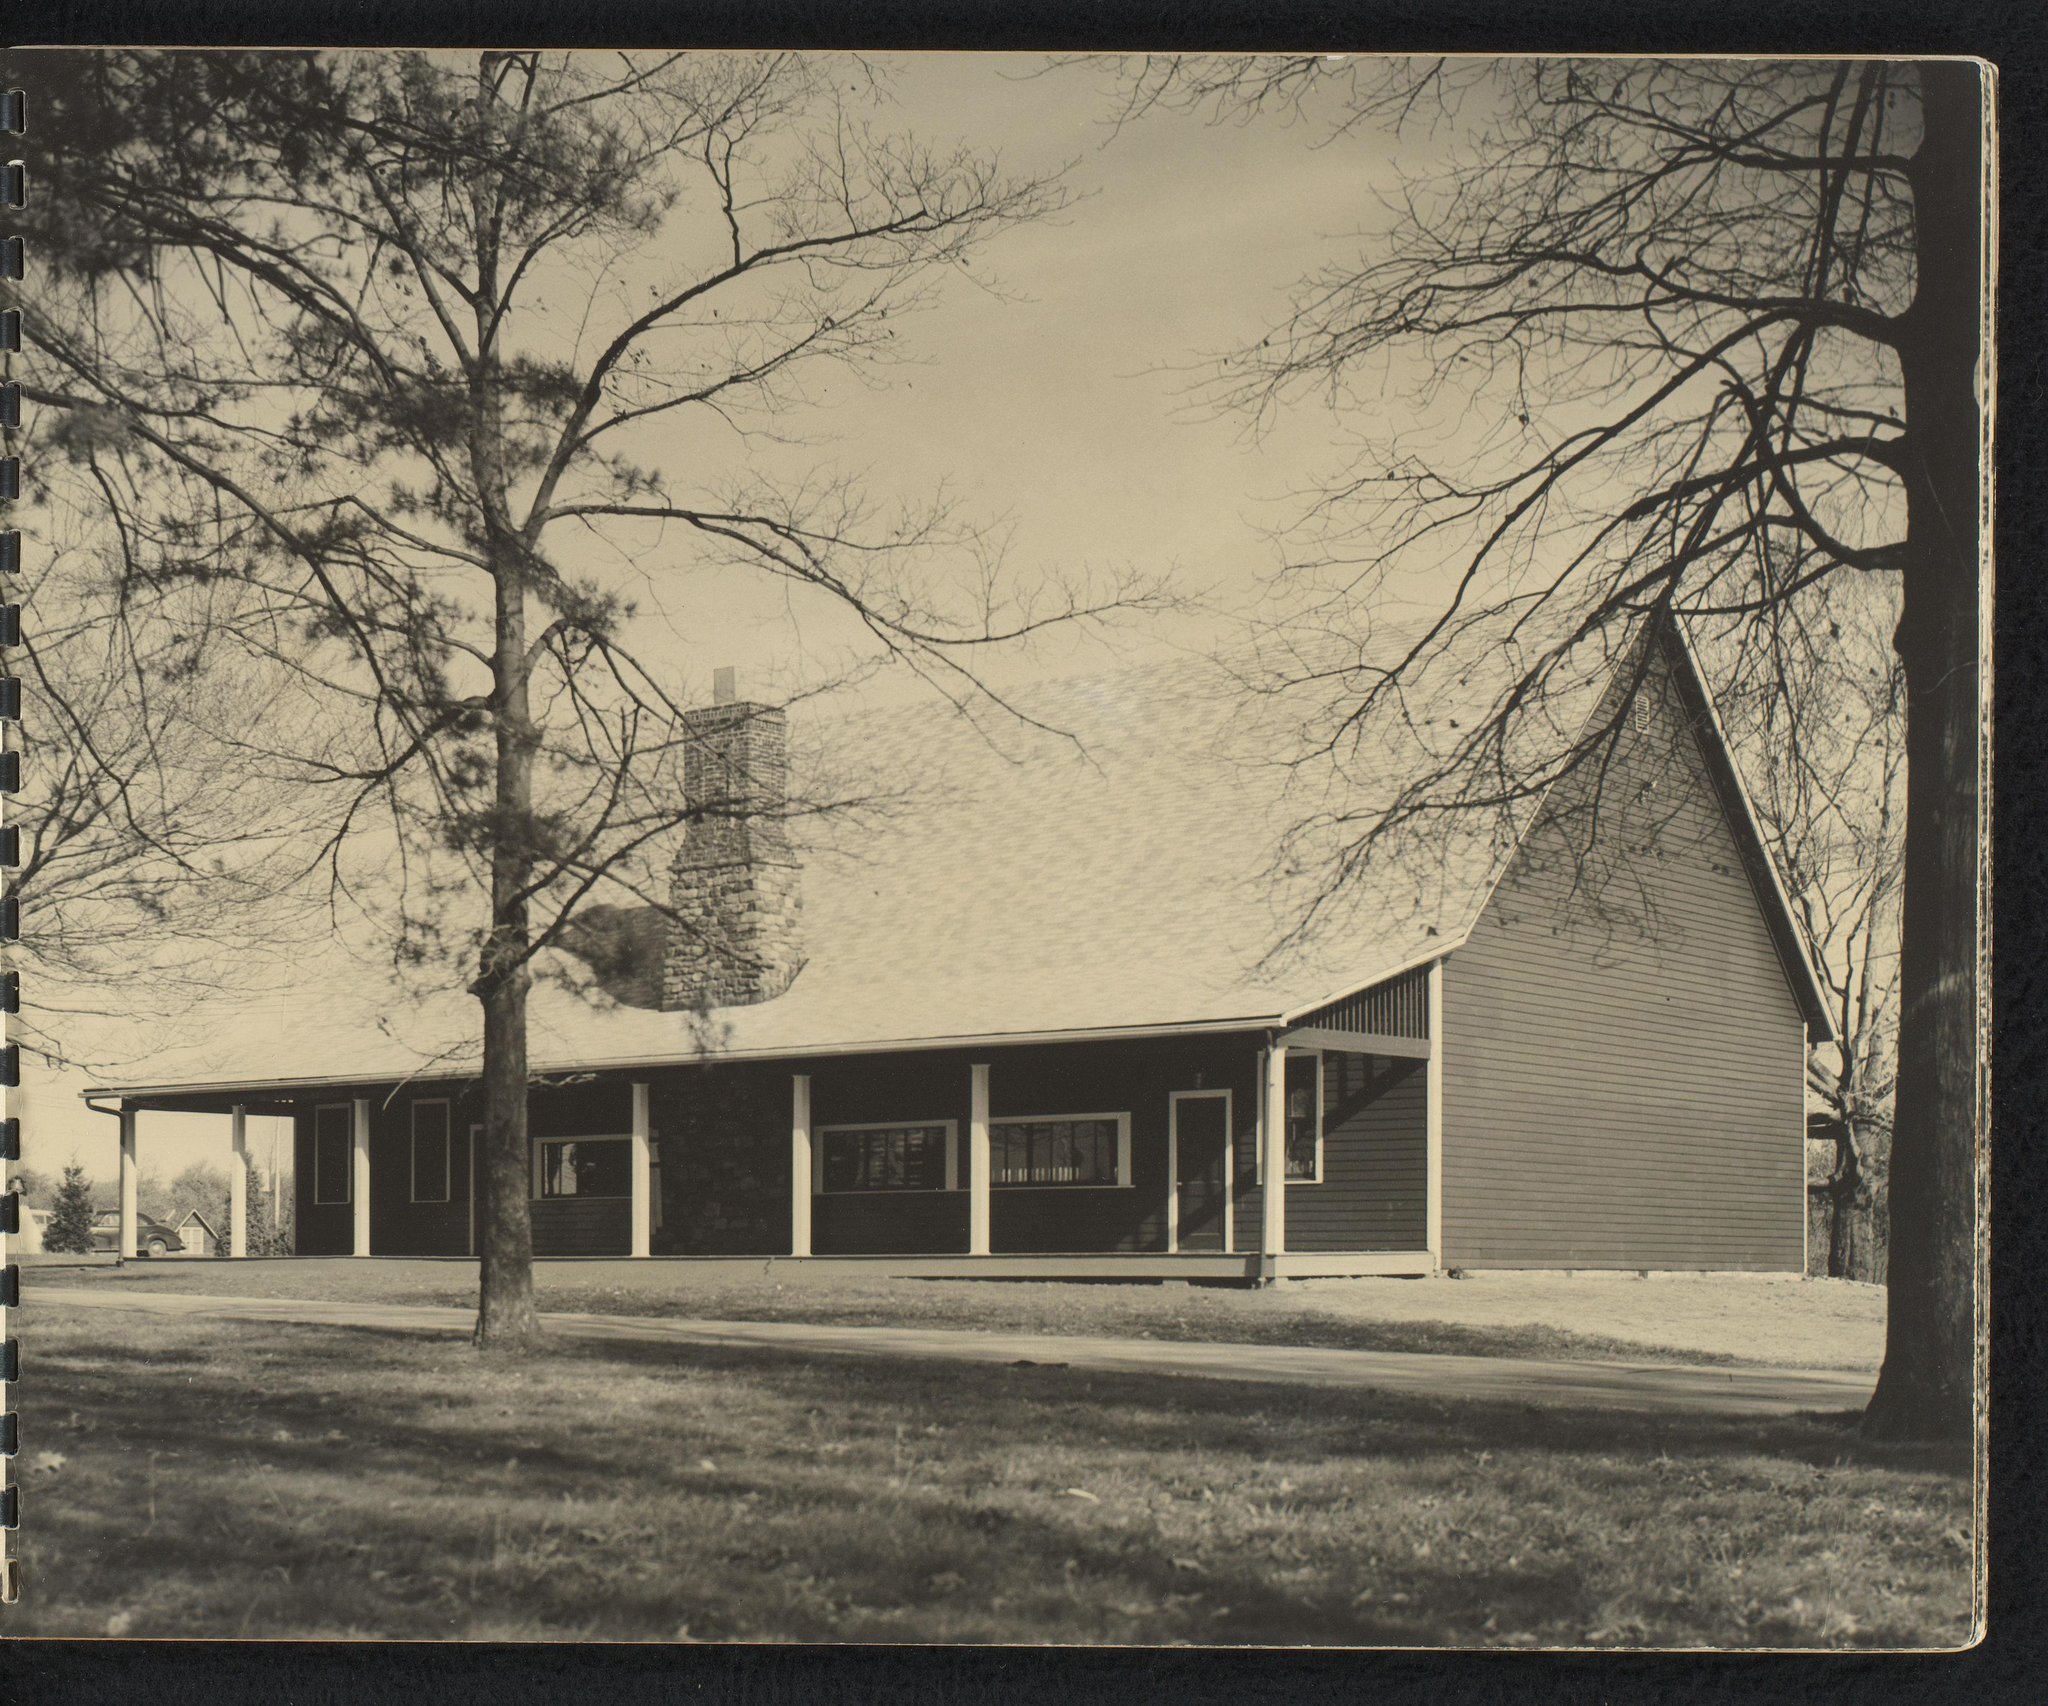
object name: photograph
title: Gymnastiekgebouw (‘Gymnasium’)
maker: Anonymous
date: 1950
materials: paper, photographic support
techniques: gelatin silver print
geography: new york city